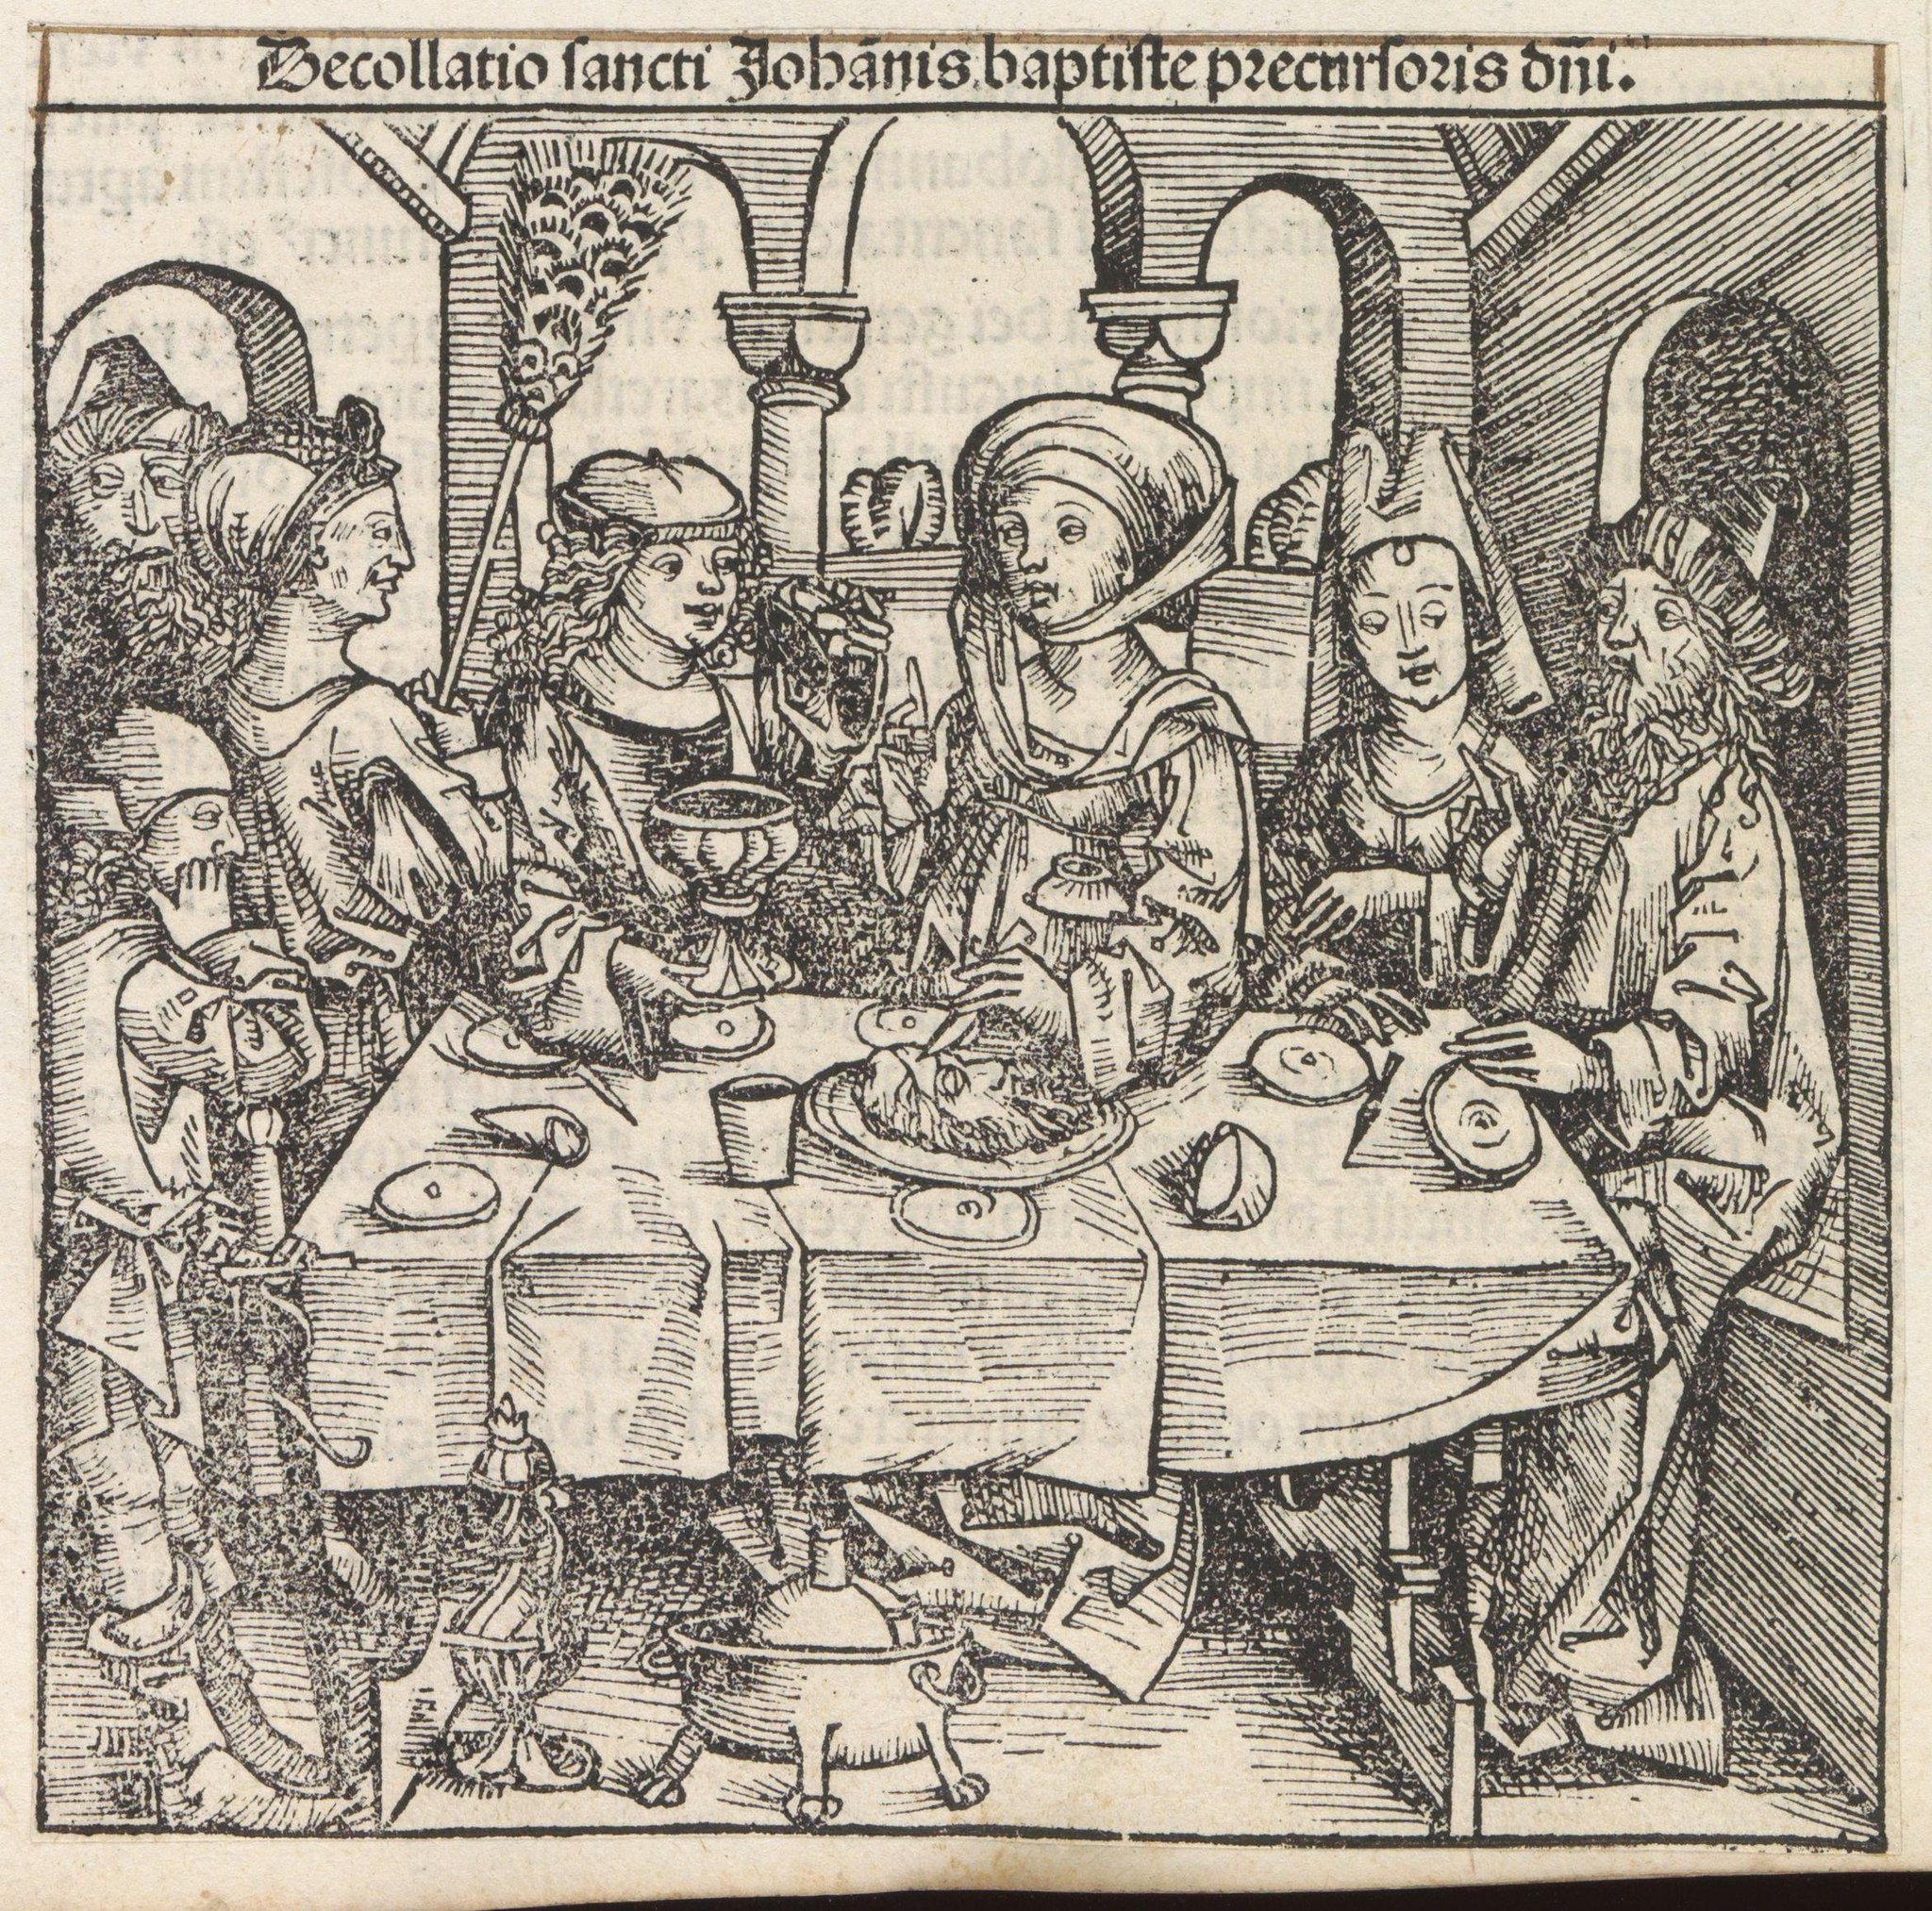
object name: album leaf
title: Liber Chronicarum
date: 1493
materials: paper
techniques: letterpress printing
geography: nuremberg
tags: salome gives the head of john the baptist to her mother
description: De houtsnede wordt gebruikt als boekillustratie in de Liber Chronicarum (of Neurenbergkroniek) van Hartmann Schedel, verschenen in het Latijn en Duits in 1493. Zie de Latijnse uitgave, folio 94v.